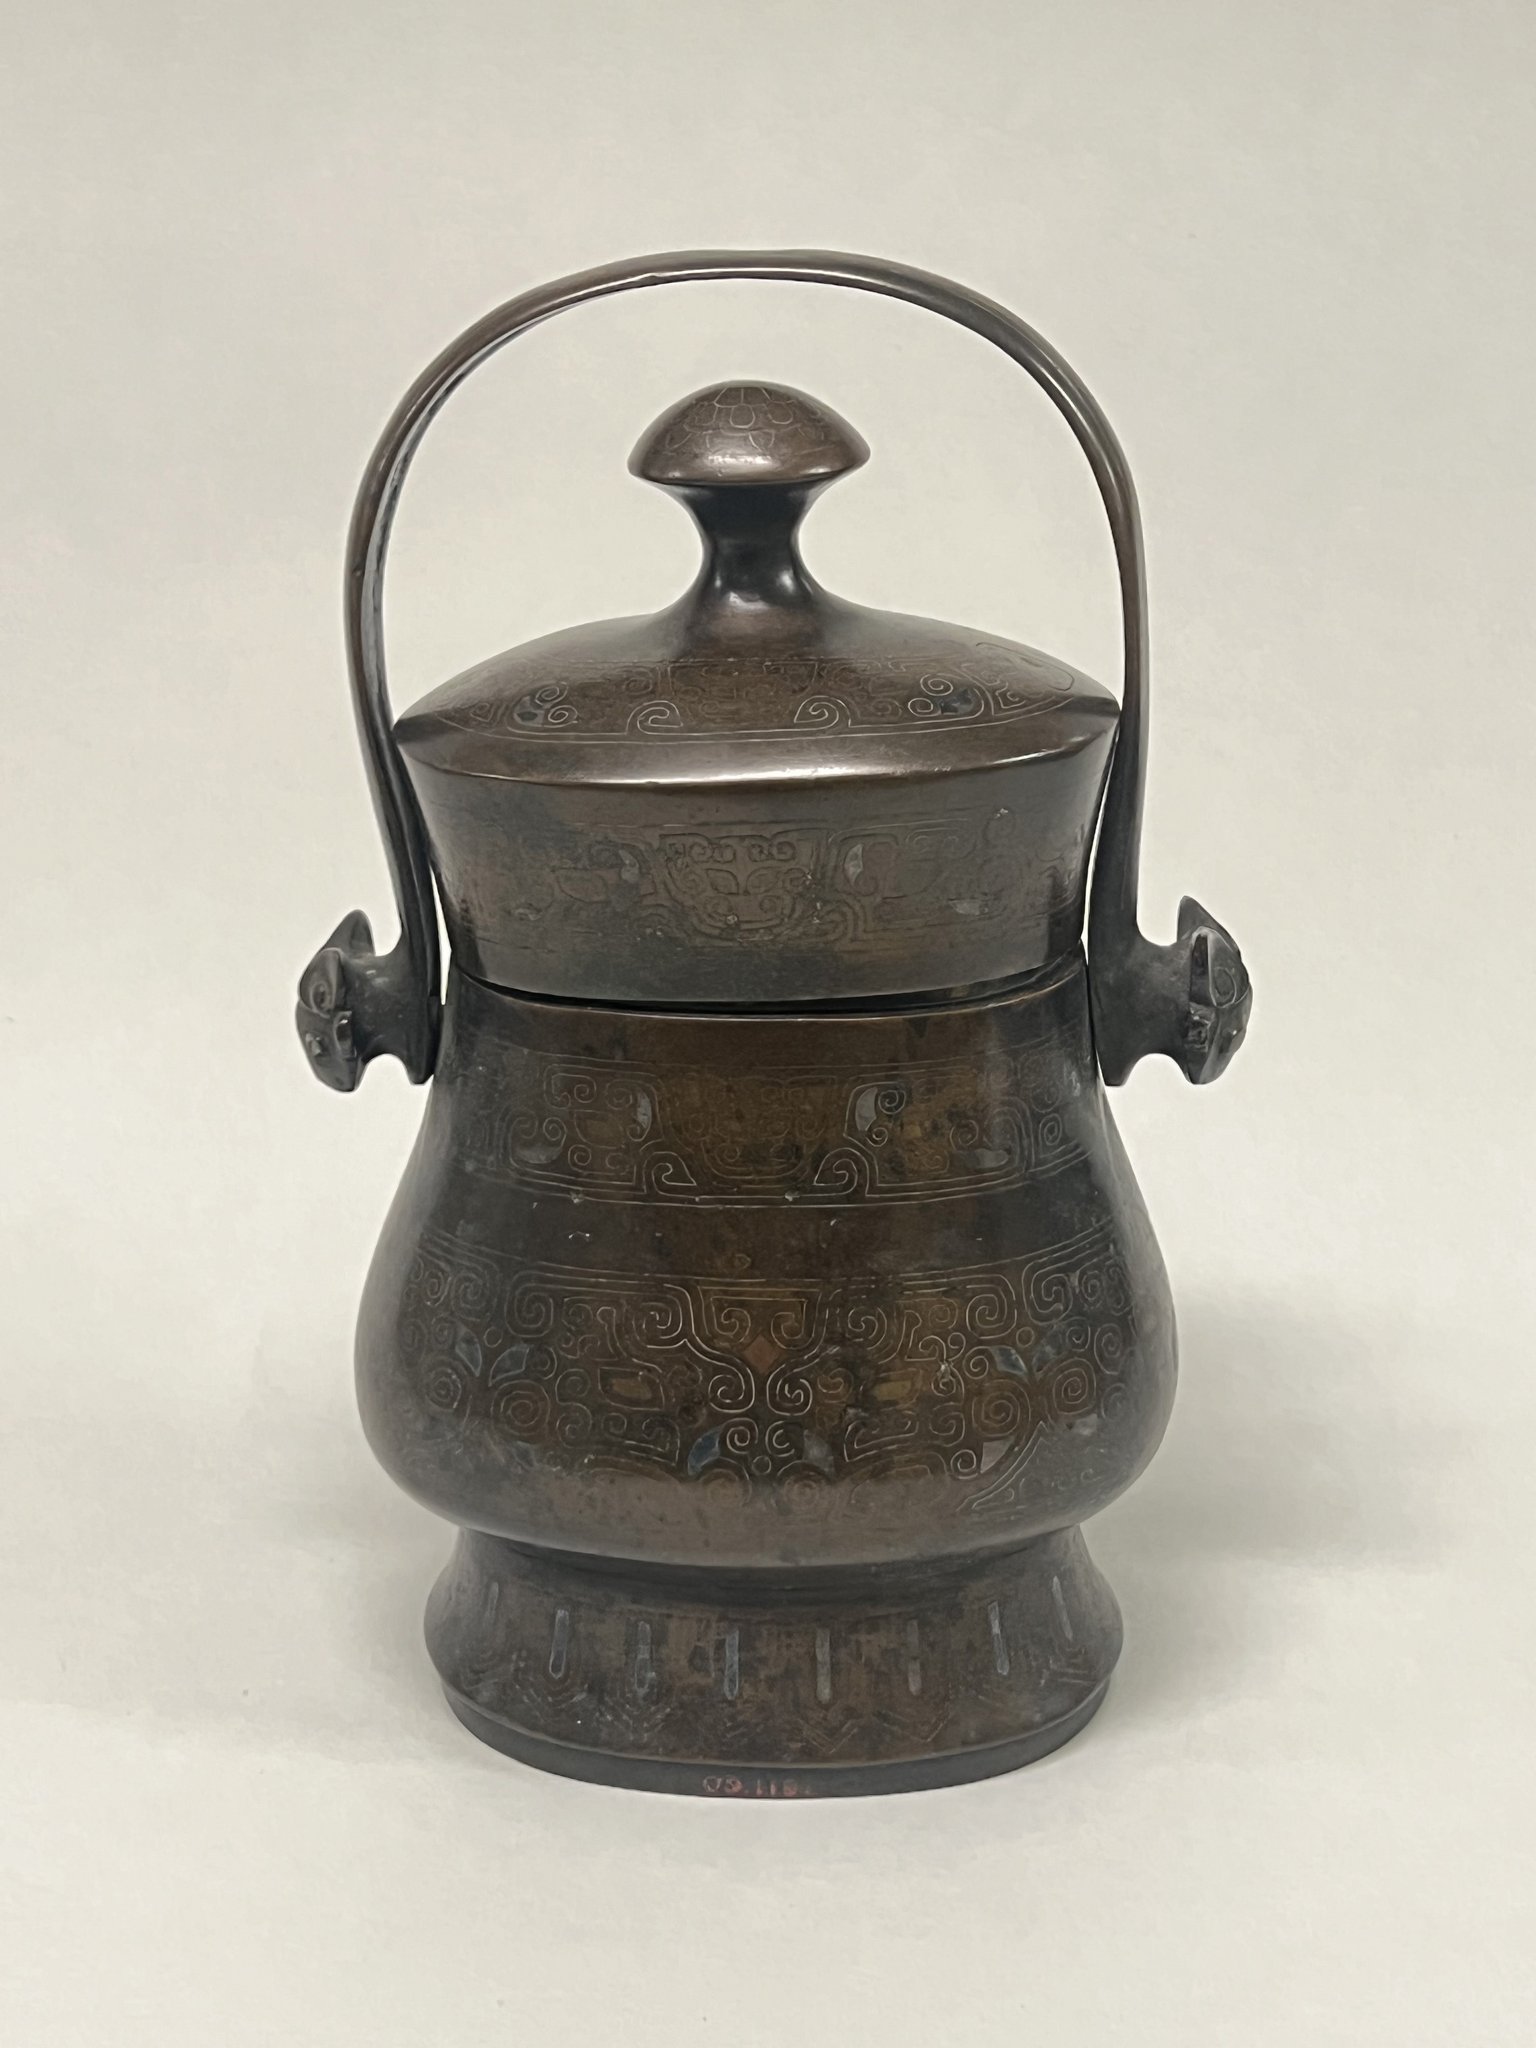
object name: vessel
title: Wine Vessel of Archaistic Design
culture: chinese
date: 1501-1700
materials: brass, bronze, gold, silver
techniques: inlay